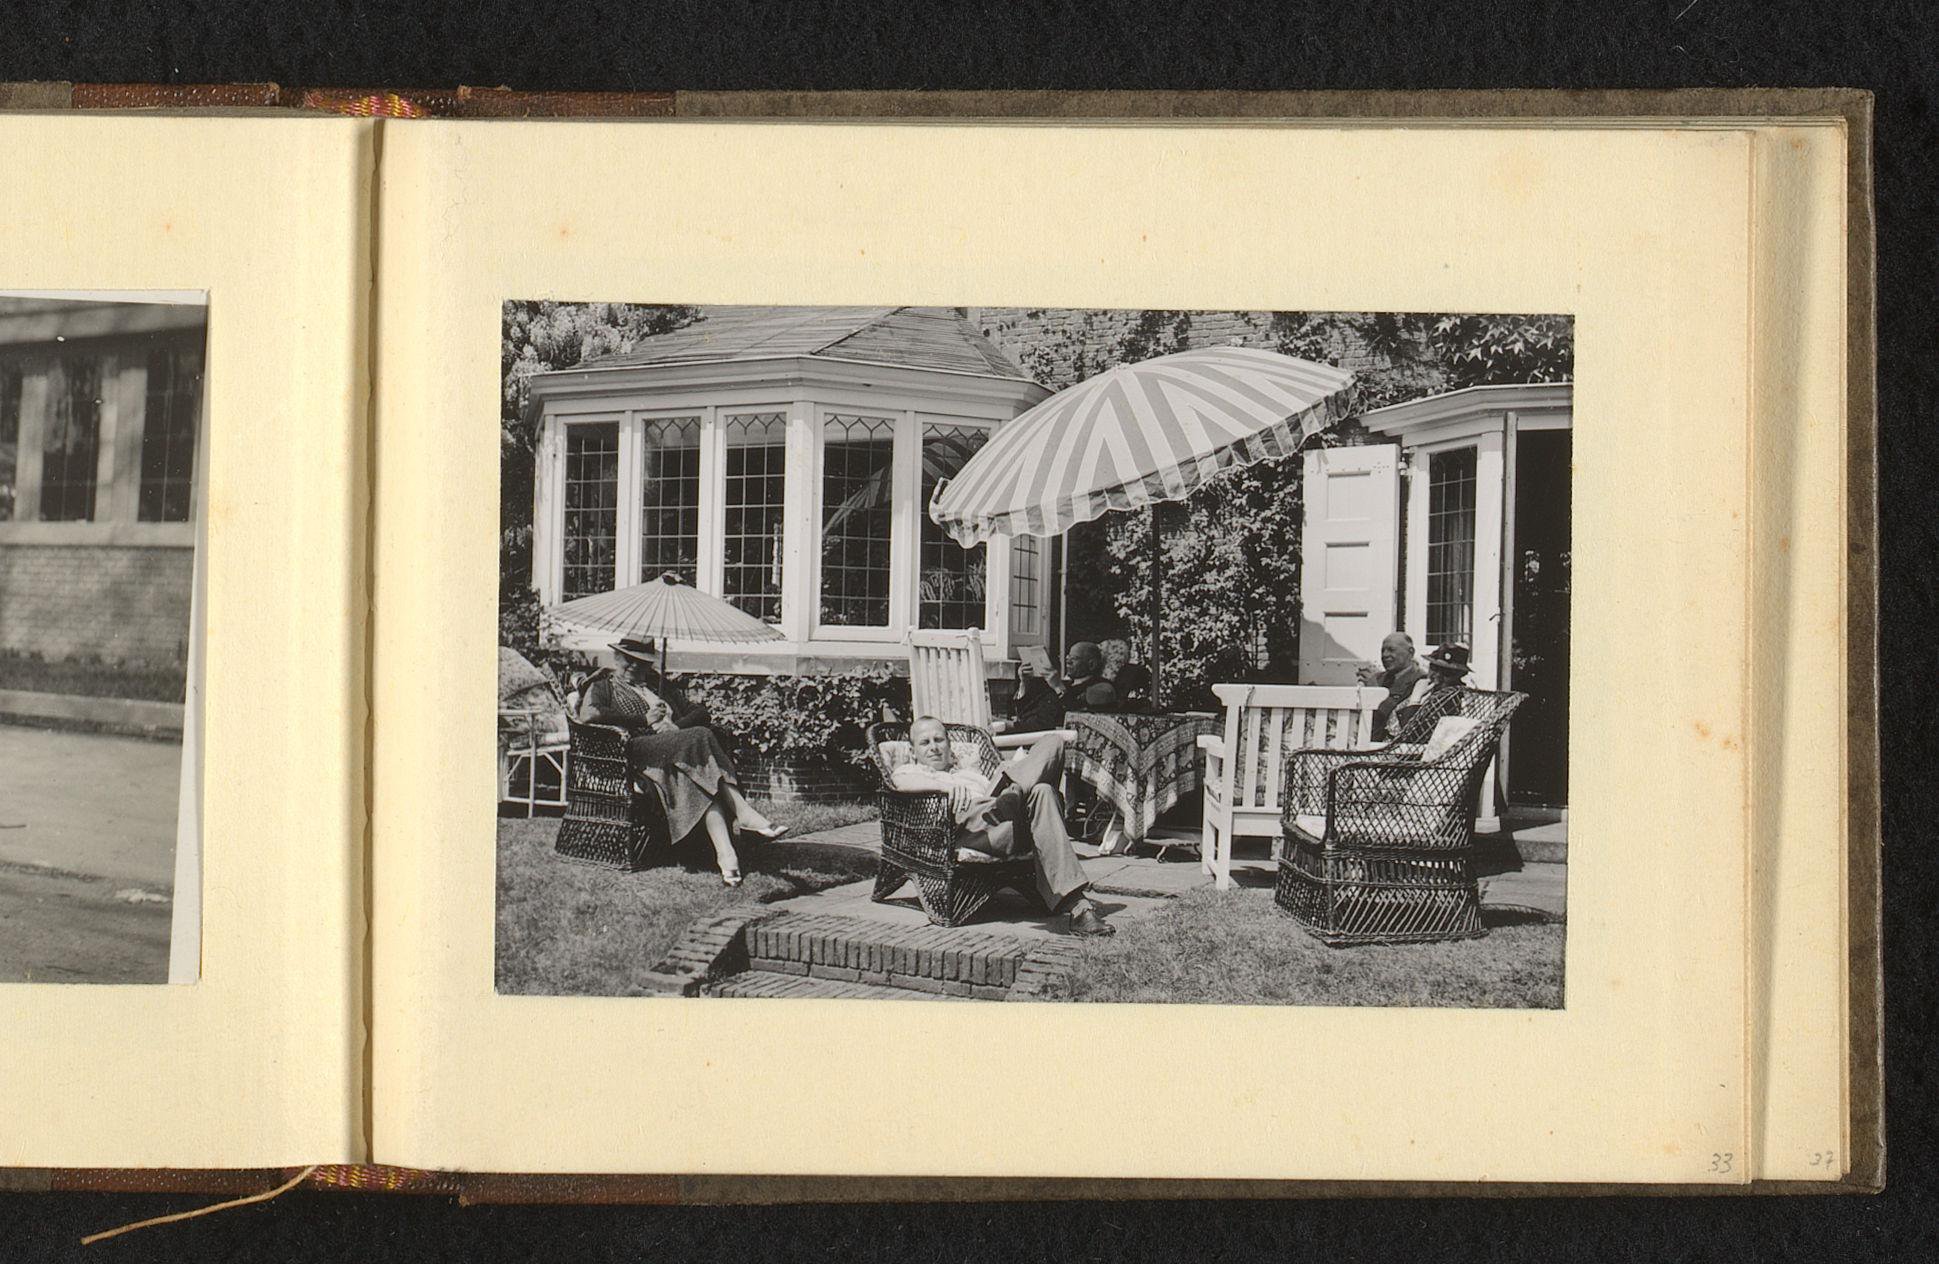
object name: photograph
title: Mensen op een terras in een tuin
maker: norbert van den berg (1901-1972)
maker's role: amateurfotograaf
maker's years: 1901-1972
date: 1935-1950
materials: paper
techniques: gelatin silver print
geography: netherlands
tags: garden, terrace